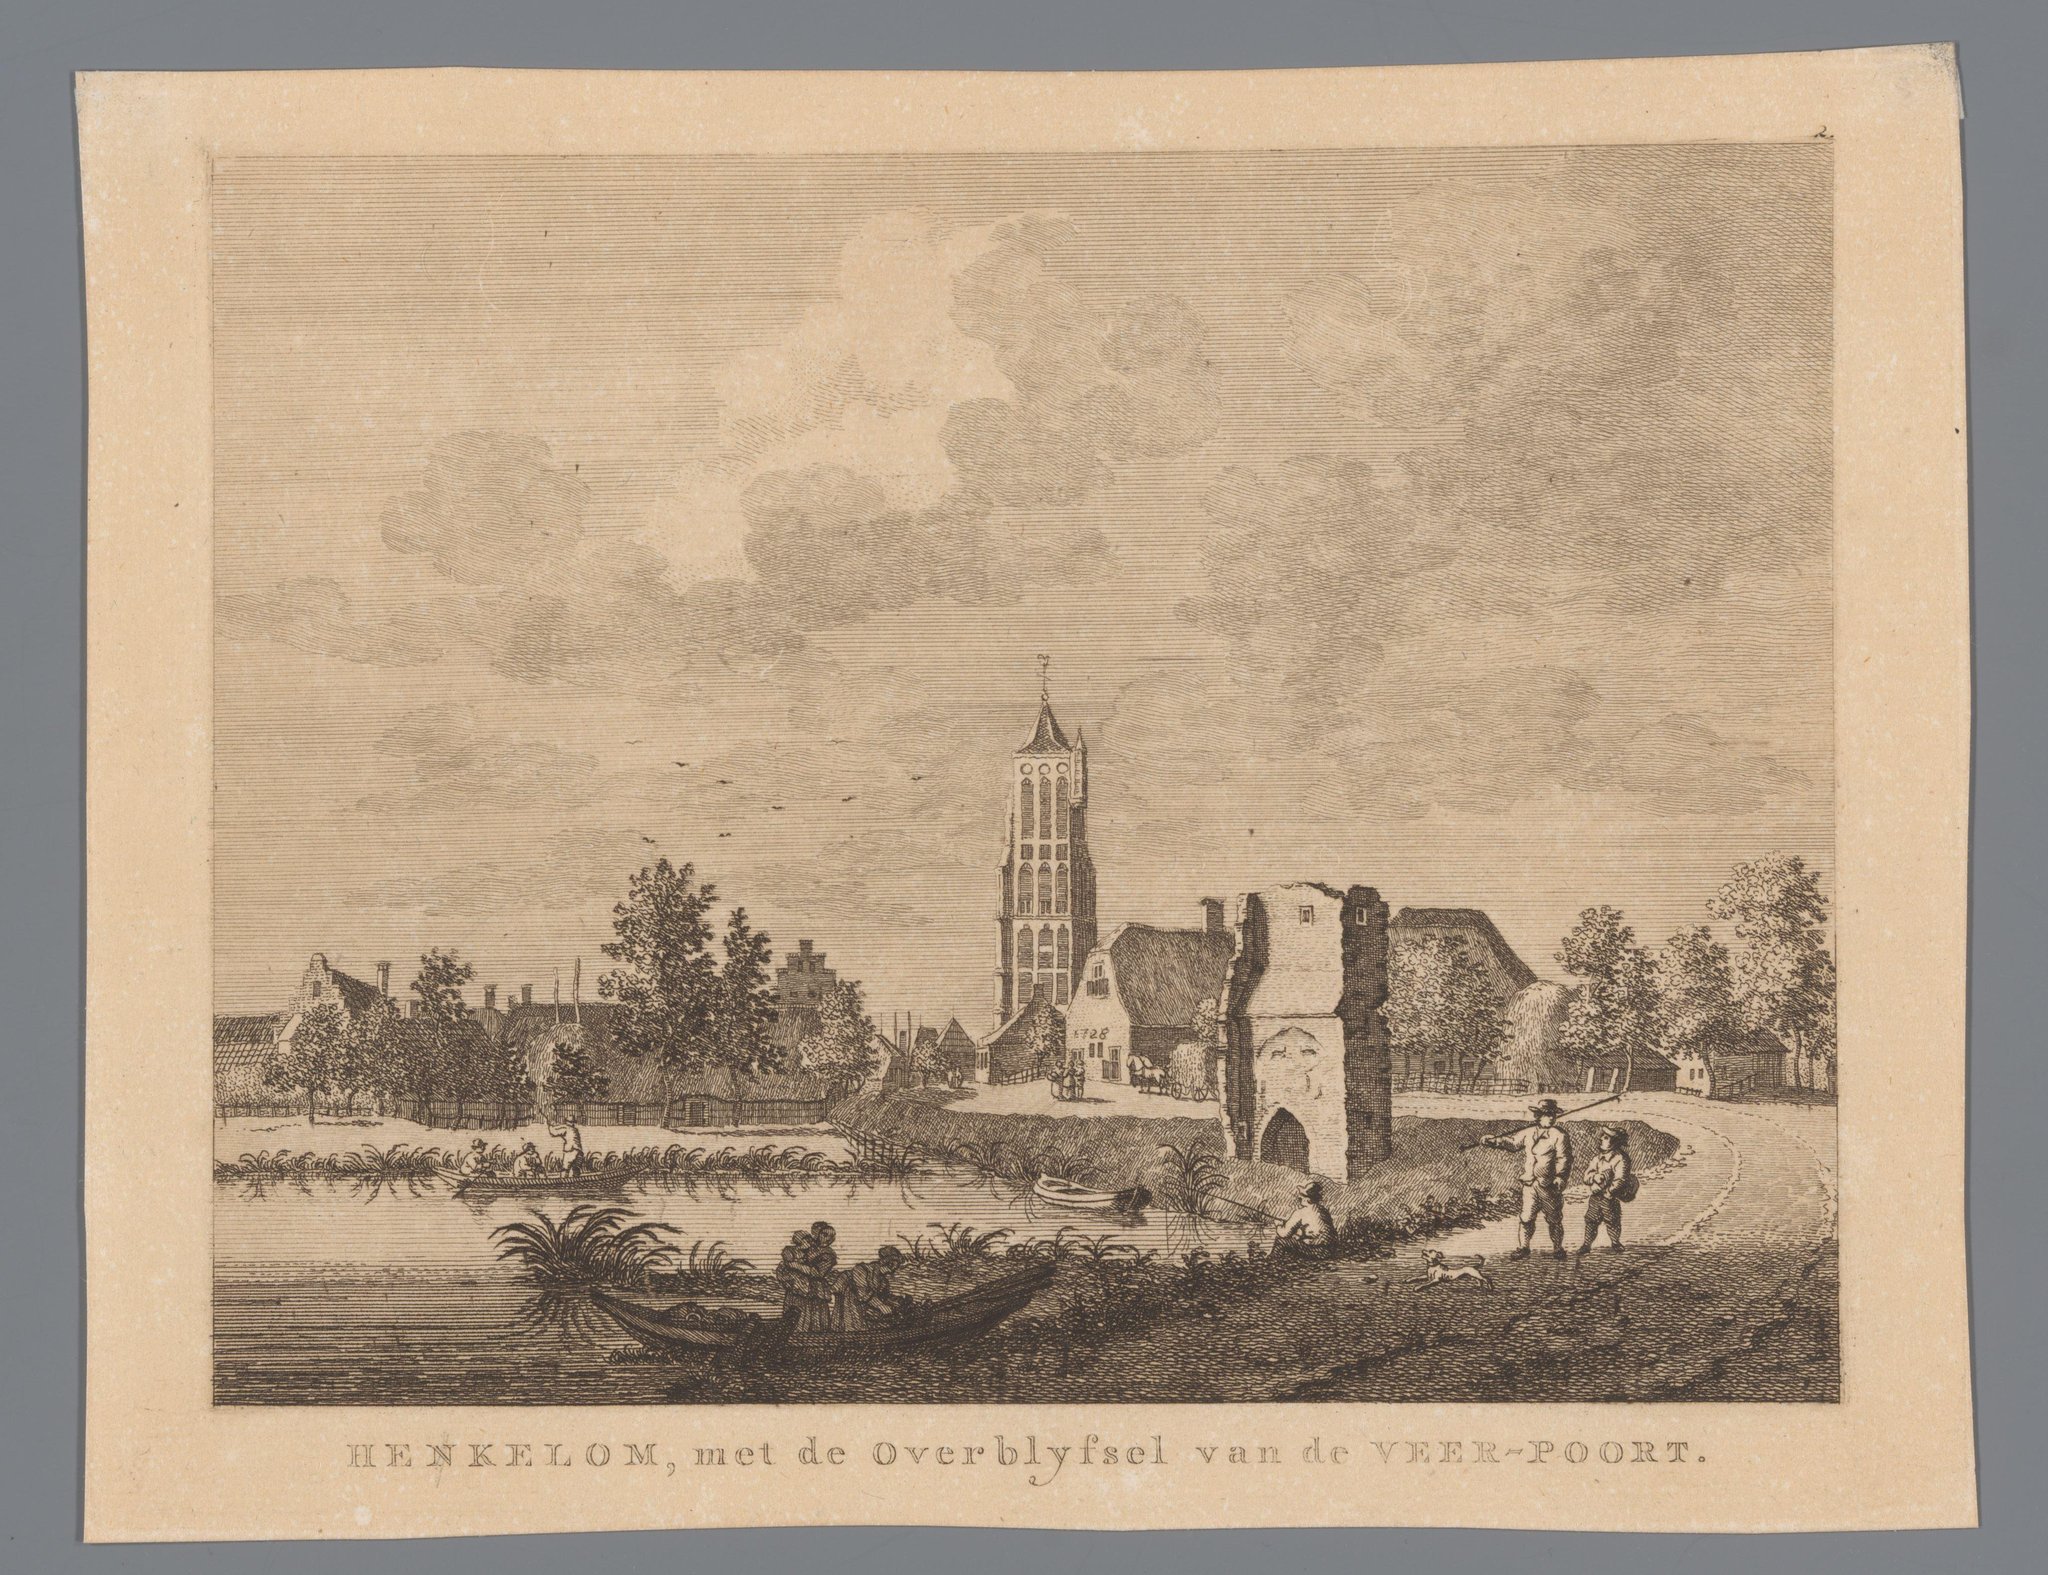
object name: print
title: Henkelom, met de overblyfsel van de veer-poort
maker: Anonymous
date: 1770-1800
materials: paper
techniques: etching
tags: river, ruin of a building ~ architecture, village (+ city(-scape) with figures, staffage)